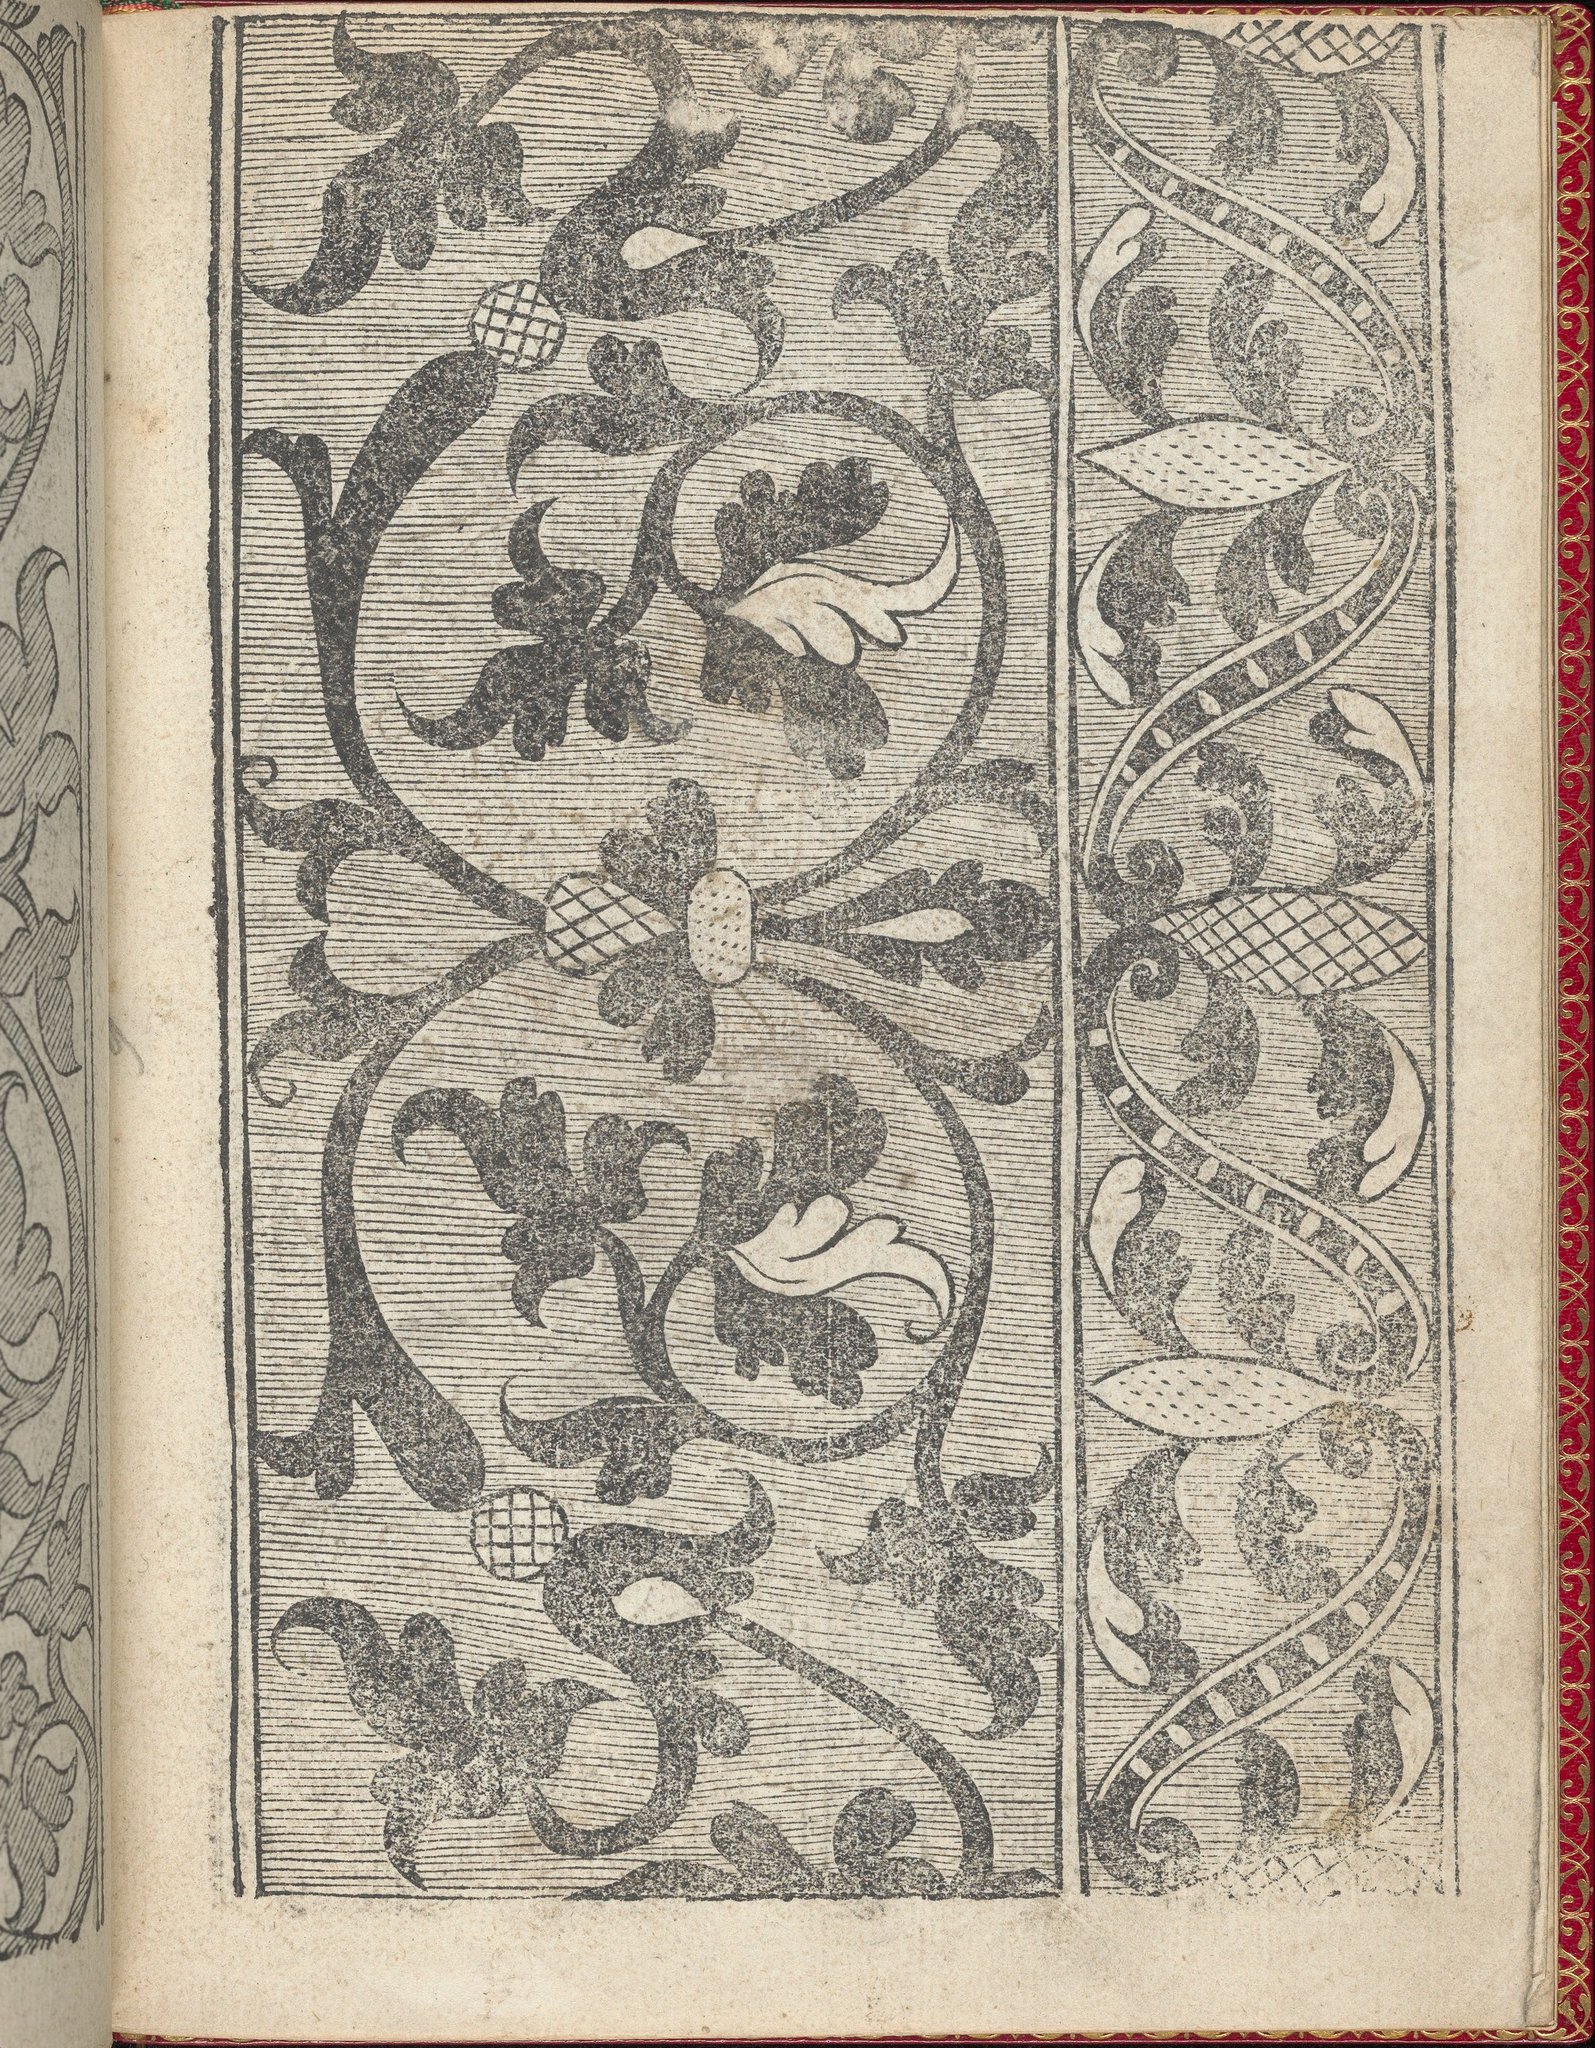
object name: book print ornament architecture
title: Il Monte. Opera Nova di Recami, page 9 (recto)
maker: giovanni antonio bindoni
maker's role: designer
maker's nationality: italian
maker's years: 1500-1650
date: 1557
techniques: woodcut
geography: italy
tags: ornament